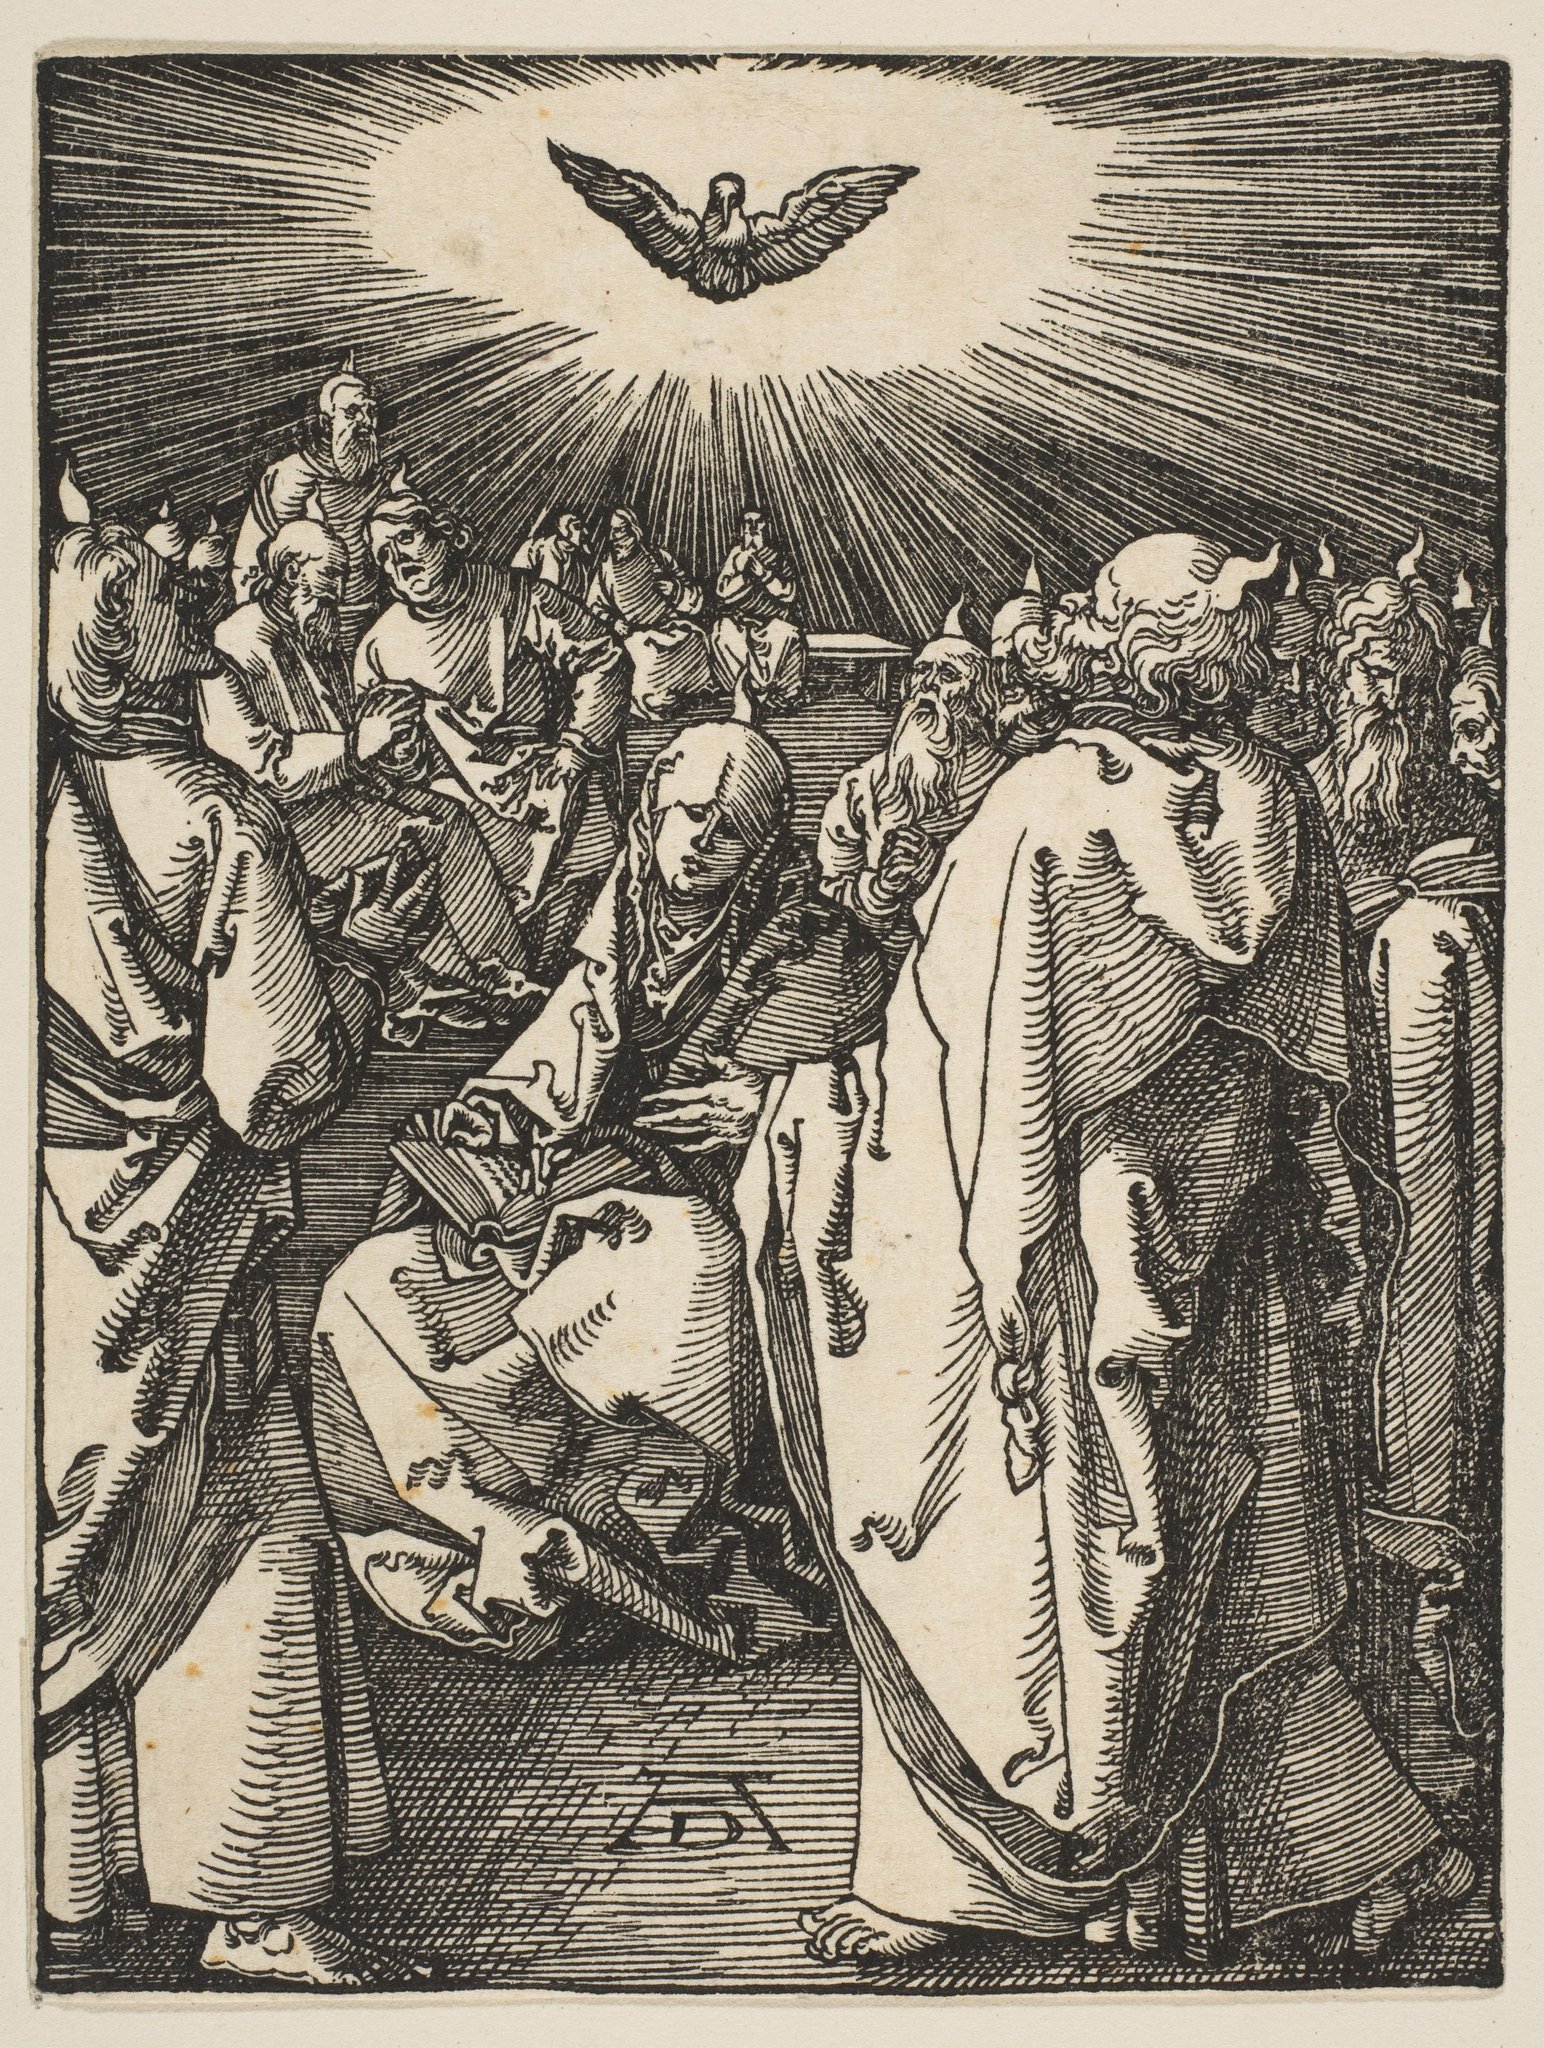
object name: print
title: Pentecost, from "The Small Passion"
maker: albrecht dürer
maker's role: artist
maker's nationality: german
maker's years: 1471-1528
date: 1510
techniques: woodcut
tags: birds,men,women,pentecost